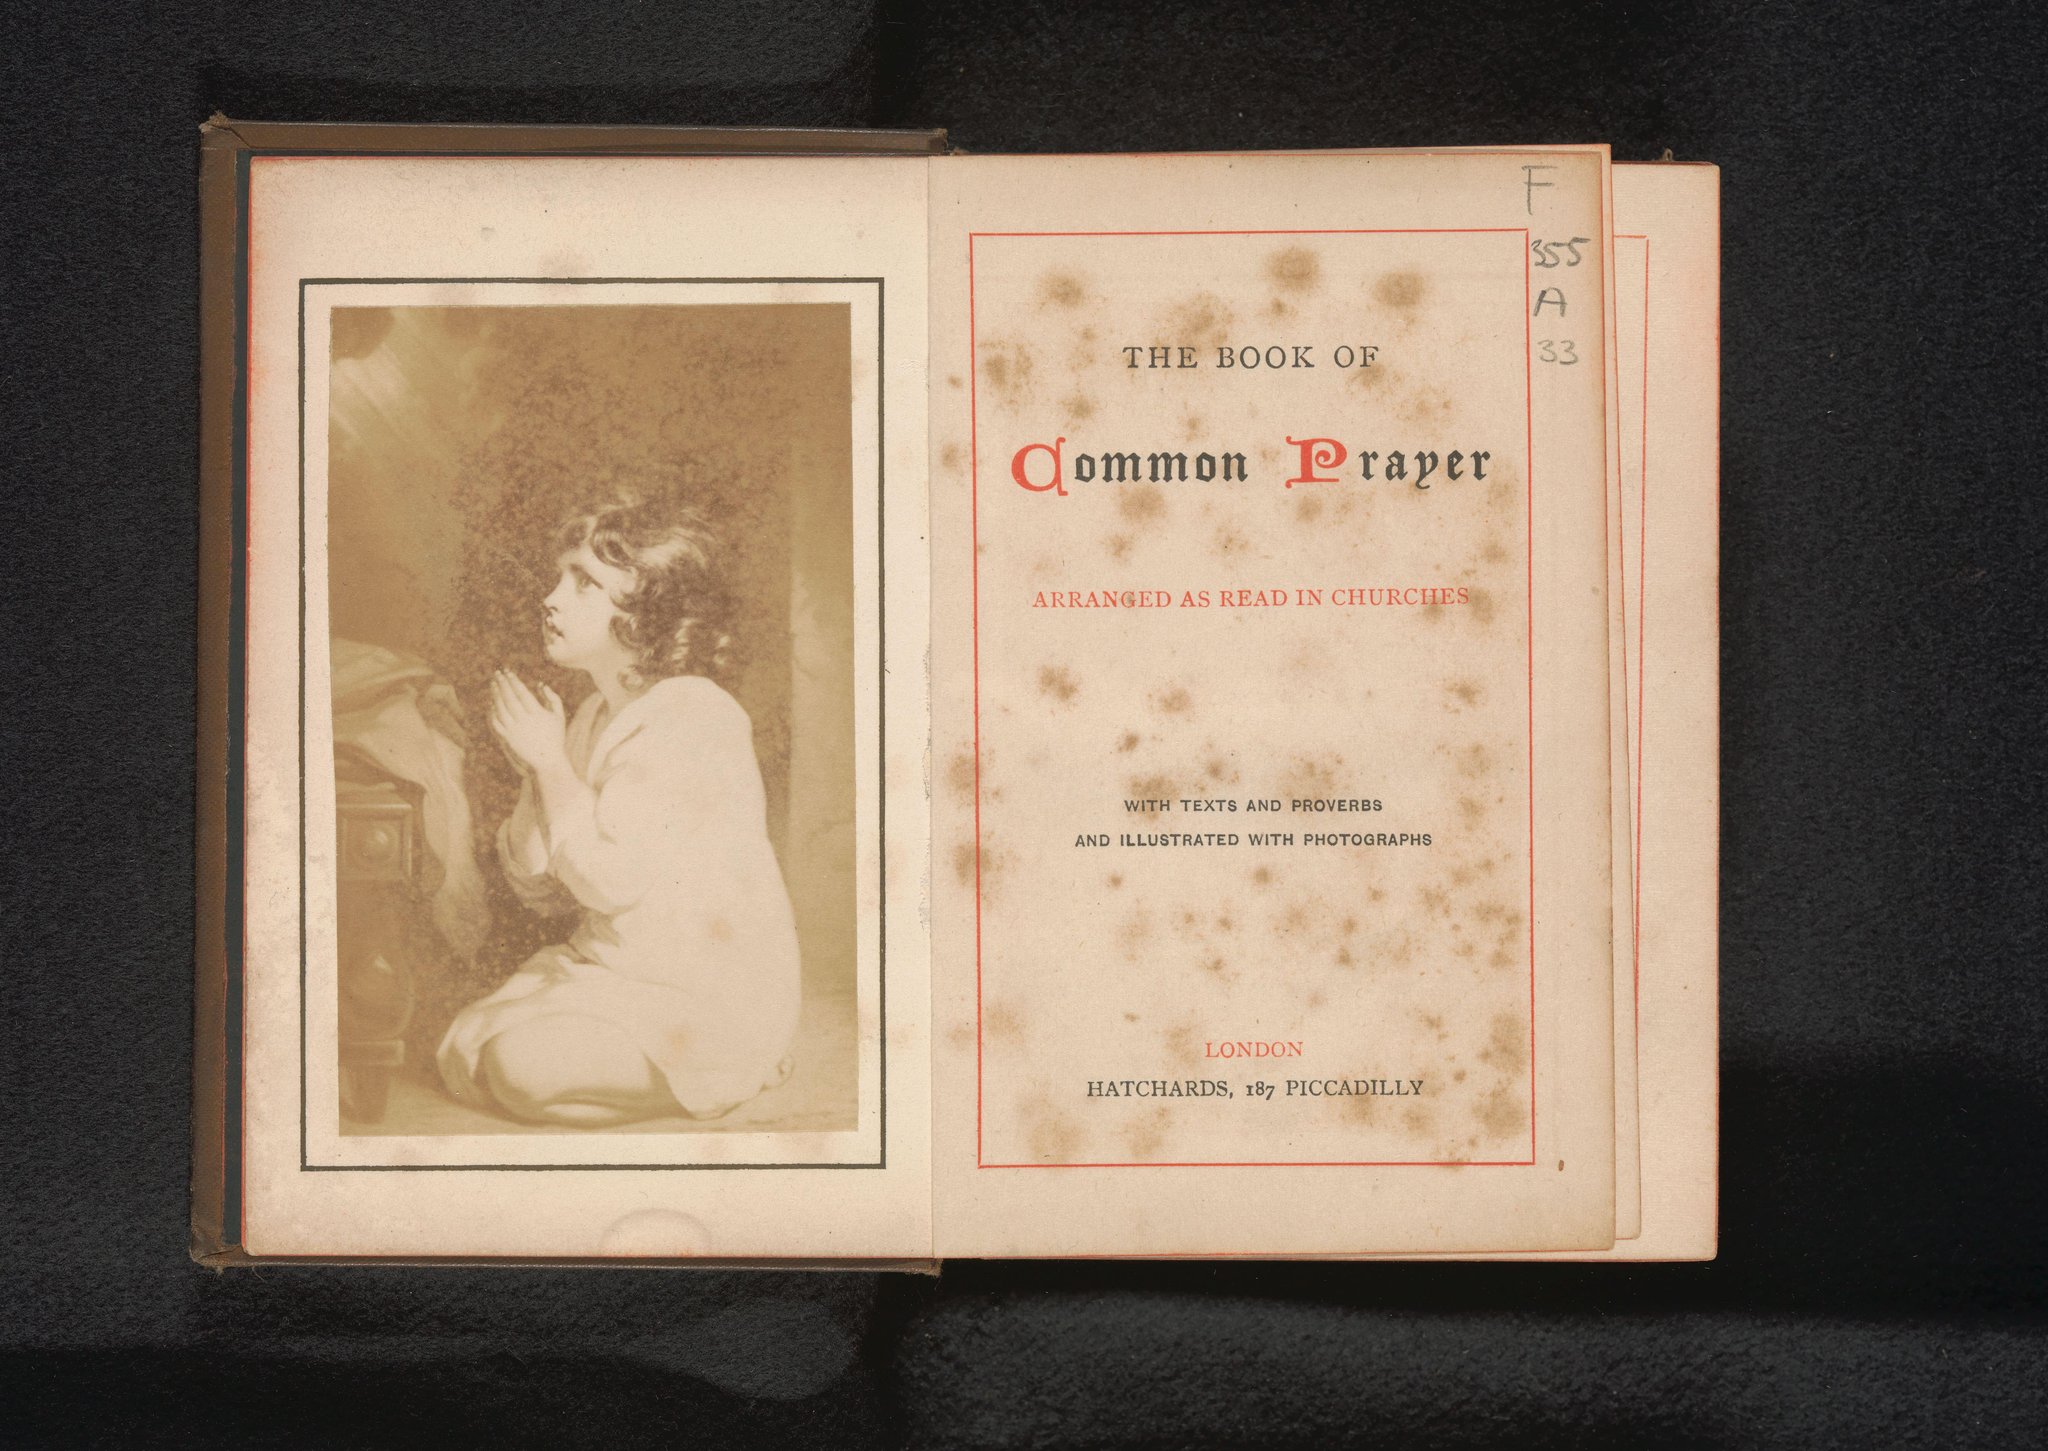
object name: photograph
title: Fotoreproductie van een schilderij, voorstellende een biddend kind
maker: Anonymous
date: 1870-1880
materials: photographic support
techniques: albumen print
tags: one person praying, child (at home)